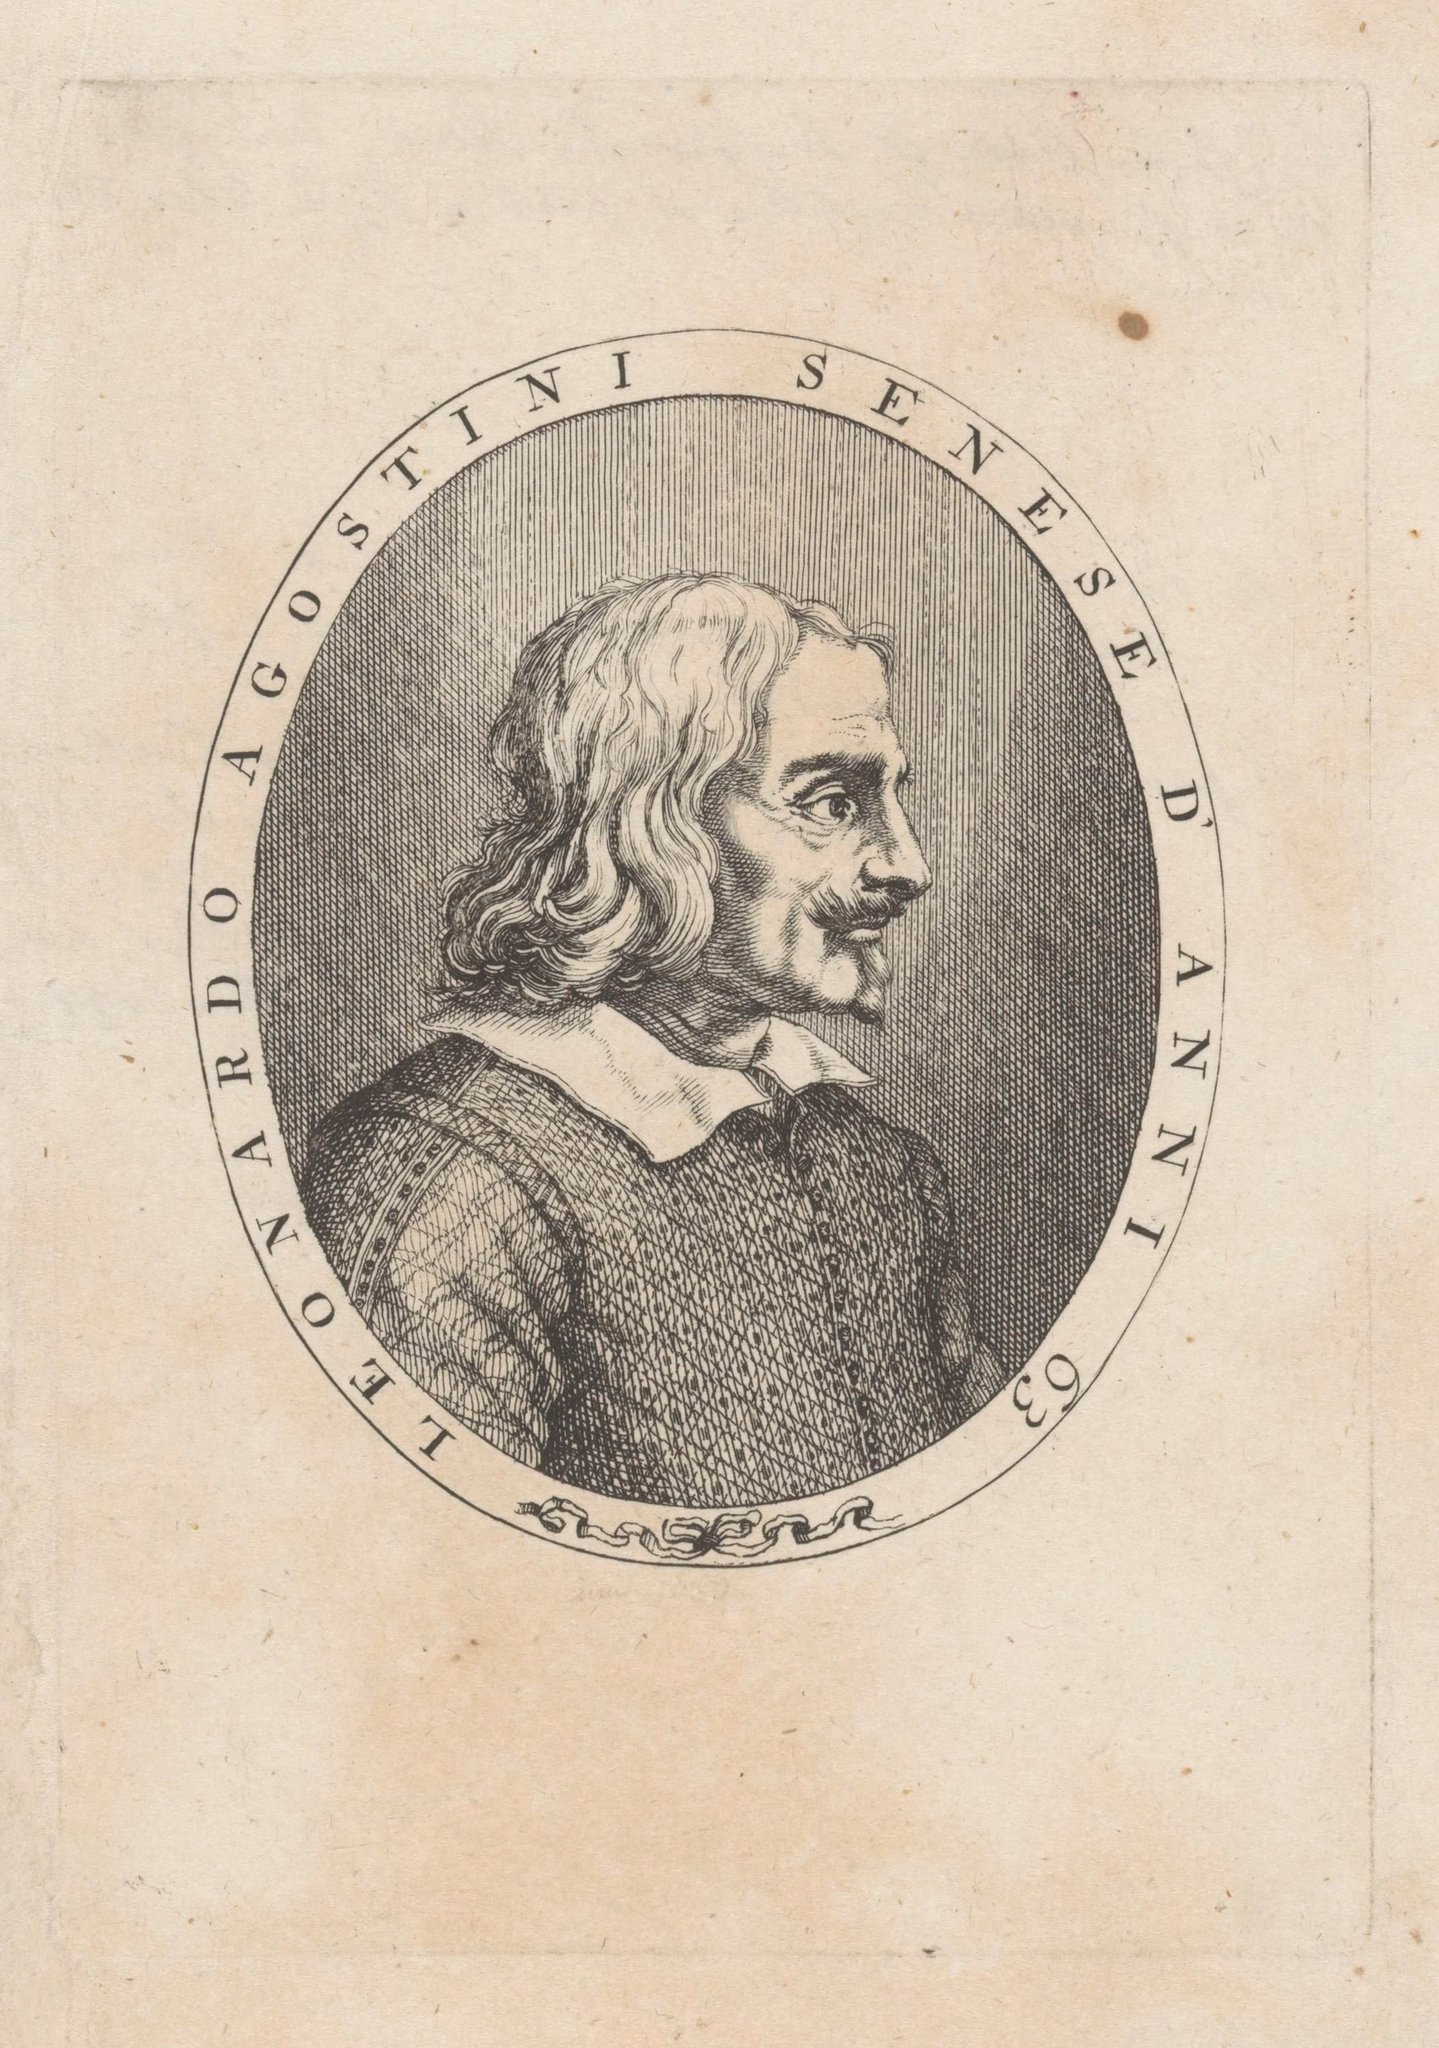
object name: print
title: Portret van Leonardo Agostini op 63-jarige leeftijd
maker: Anonymous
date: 1656-1749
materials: paper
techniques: etching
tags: grosseto, antiquaar, leonardo agostini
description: Portret van Leonardo Agostini in een ovale omlijsting met randschrift.